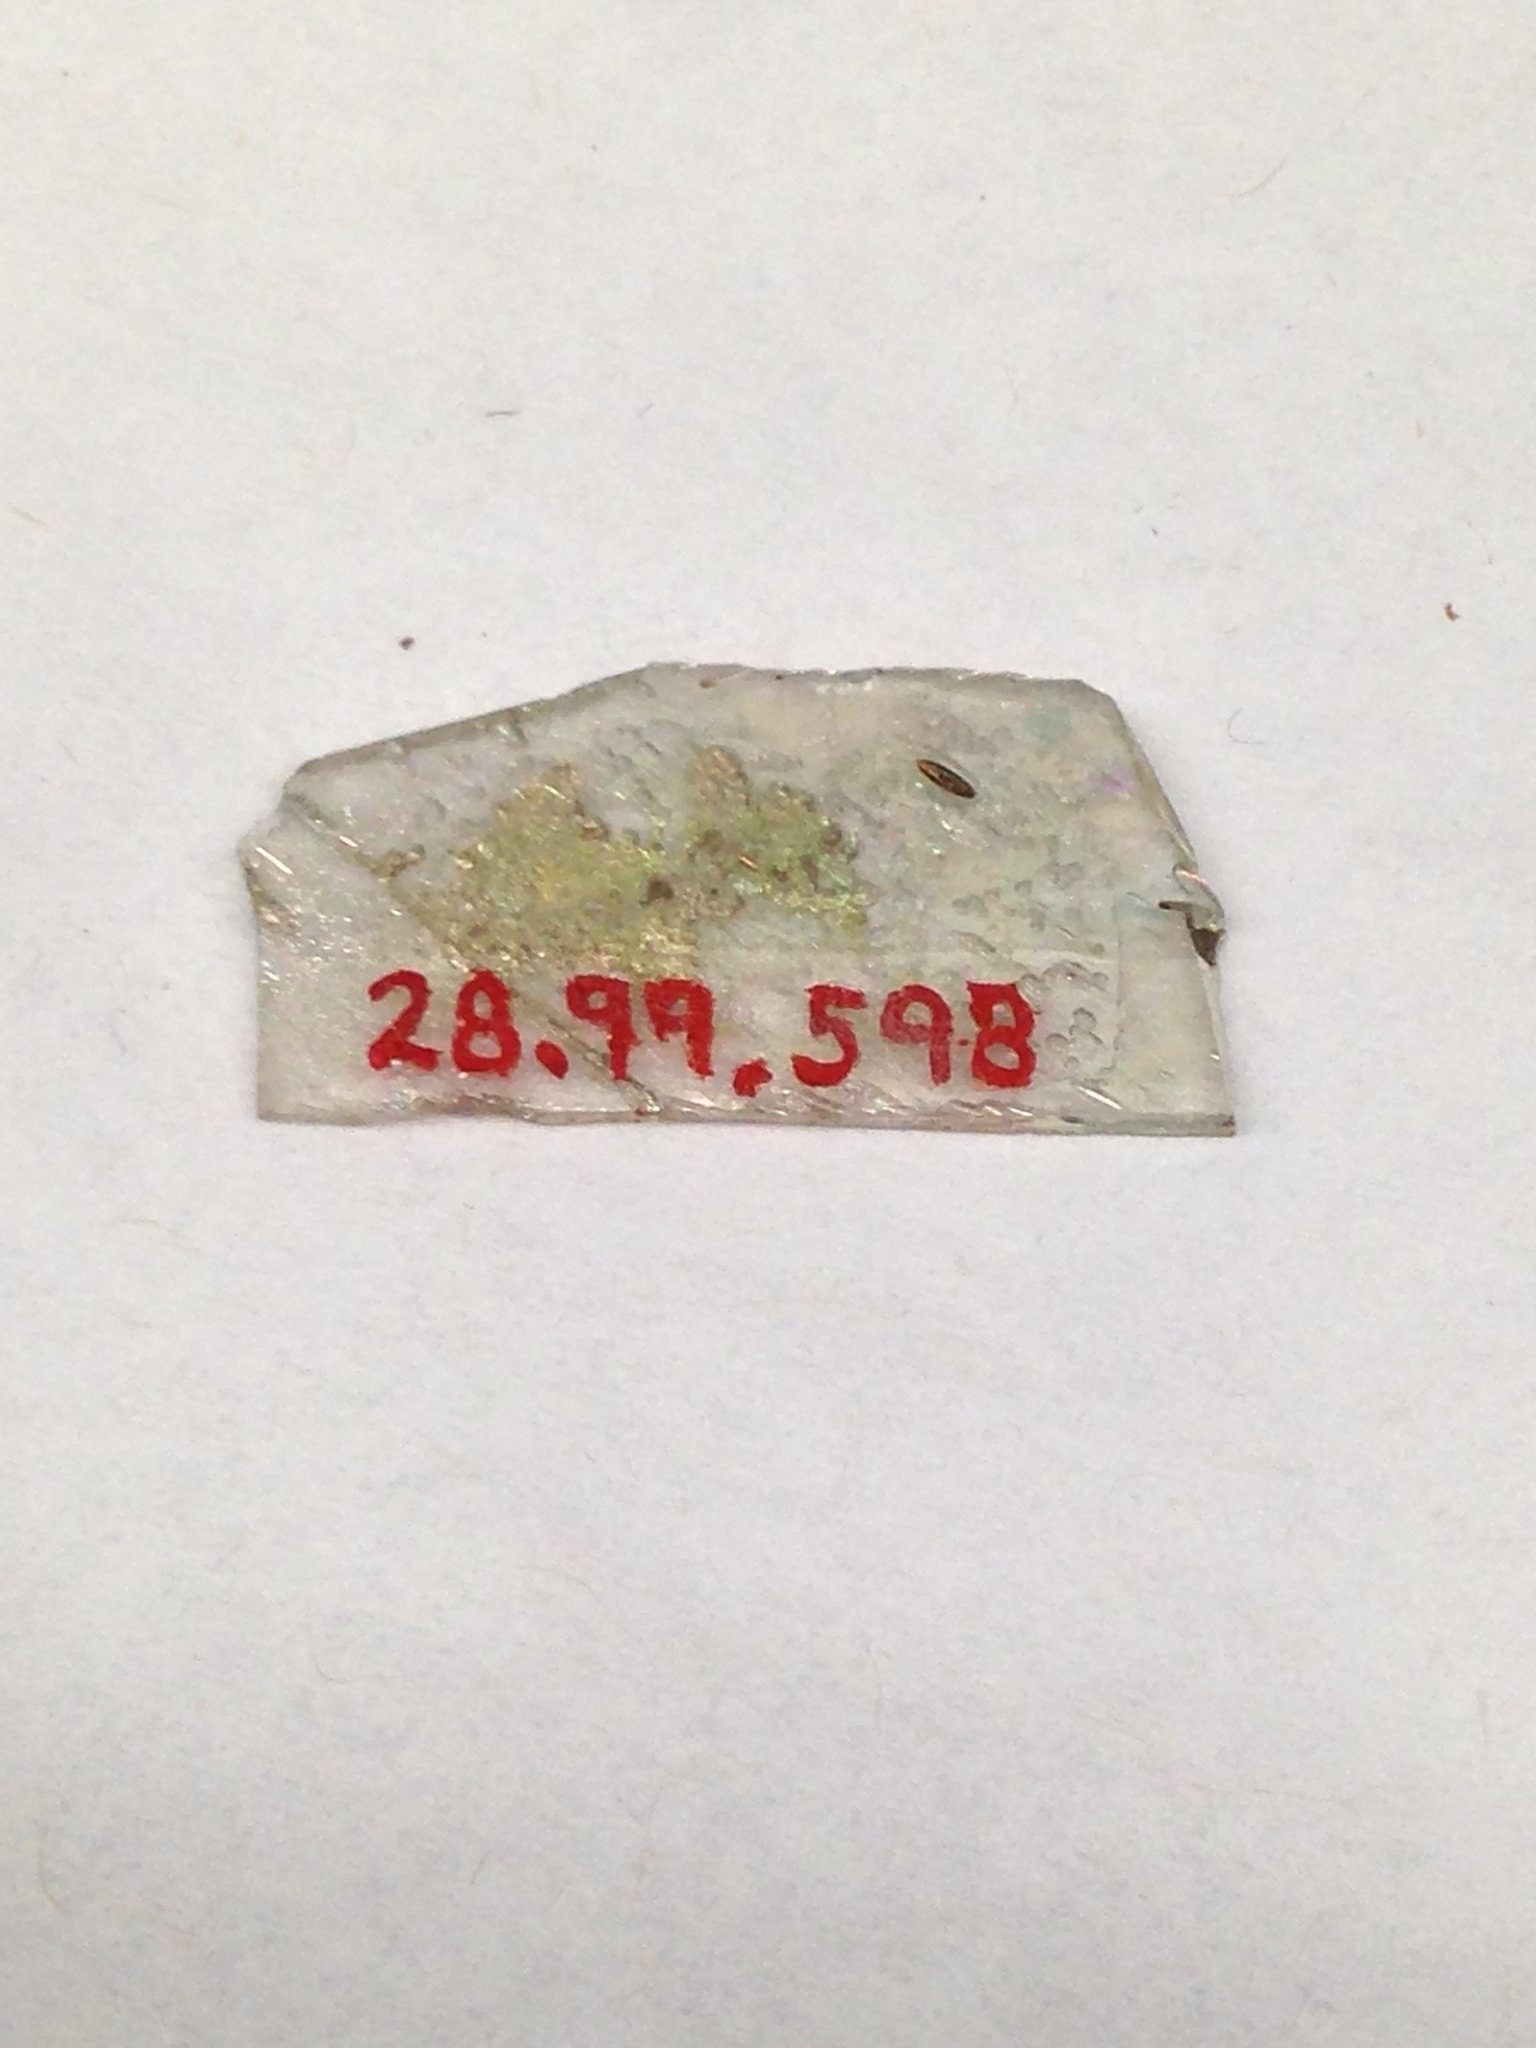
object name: fragment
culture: european or middle eastern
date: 1150-1250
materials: ceramic, glass